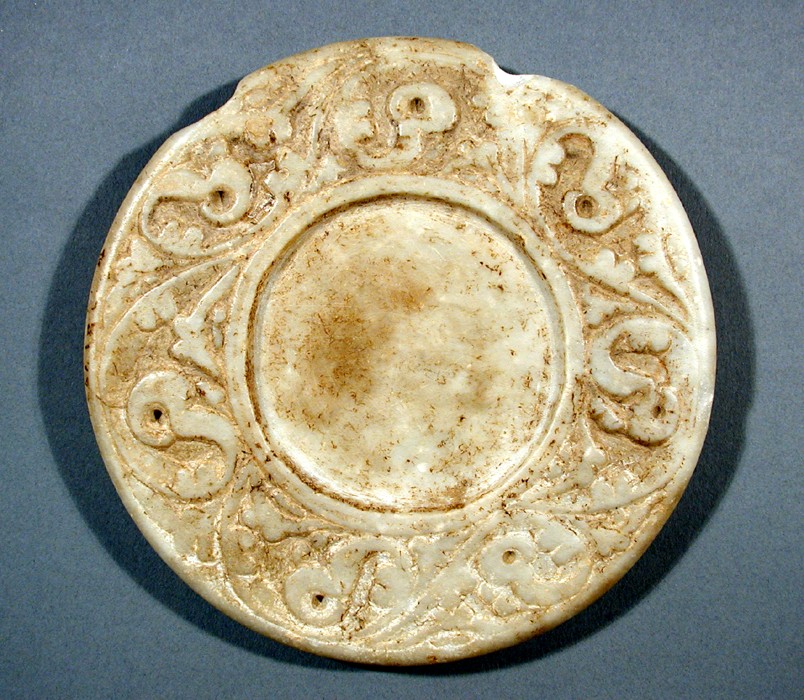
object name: tray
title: Circular Tray (Pata) with Vegetative Scrolling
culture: afghan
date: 501-700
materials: marble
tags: gandharan